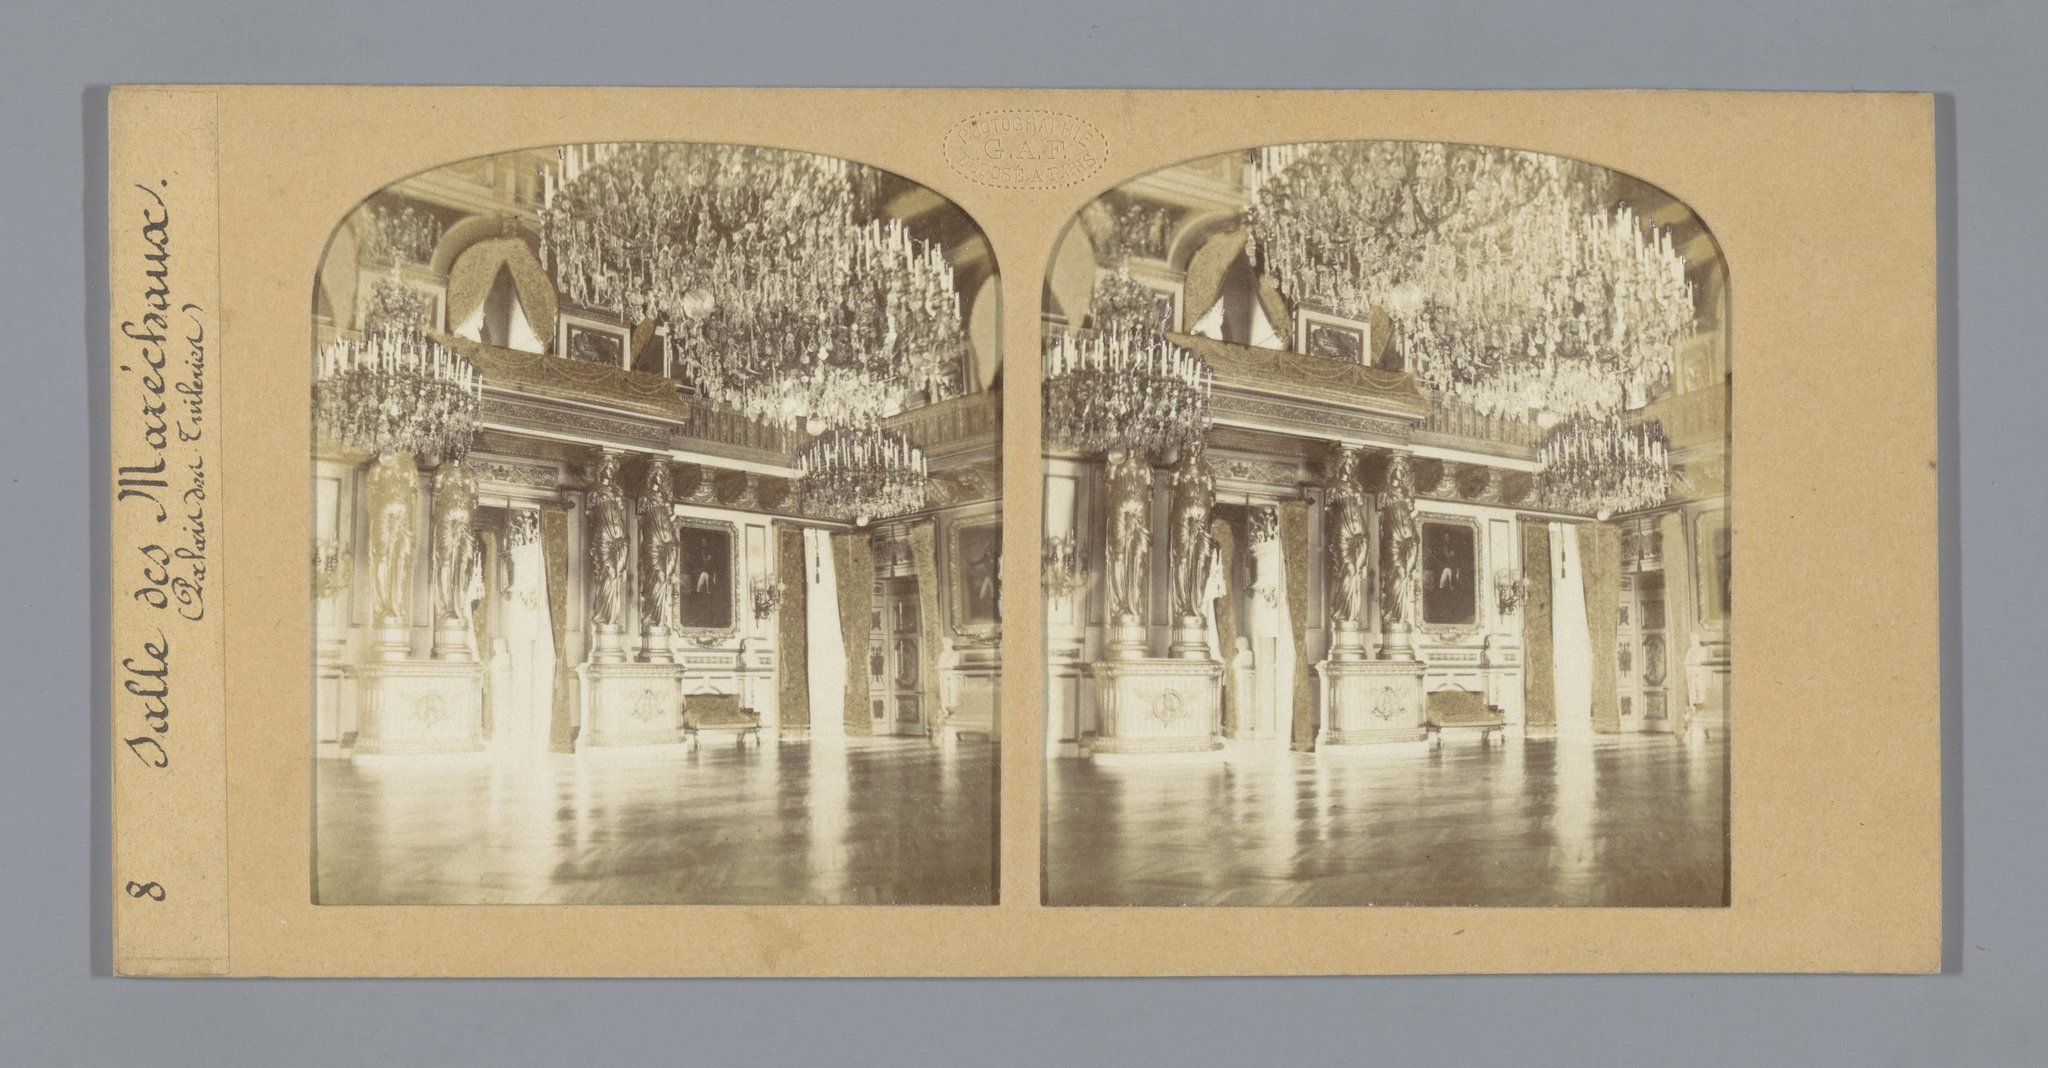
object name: tissue stereograph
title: Salle des Marécheaux (Palais des Tuileries)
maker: florent grau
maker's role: manufacturer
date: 1858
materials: cardboard, paper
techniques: albumen print, hand coloring, perforating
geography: paris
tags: palace - aa - civic architecture: inside, tuileries palace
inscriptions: inscription: ‘Déposé a Paris’, number: ‘8’